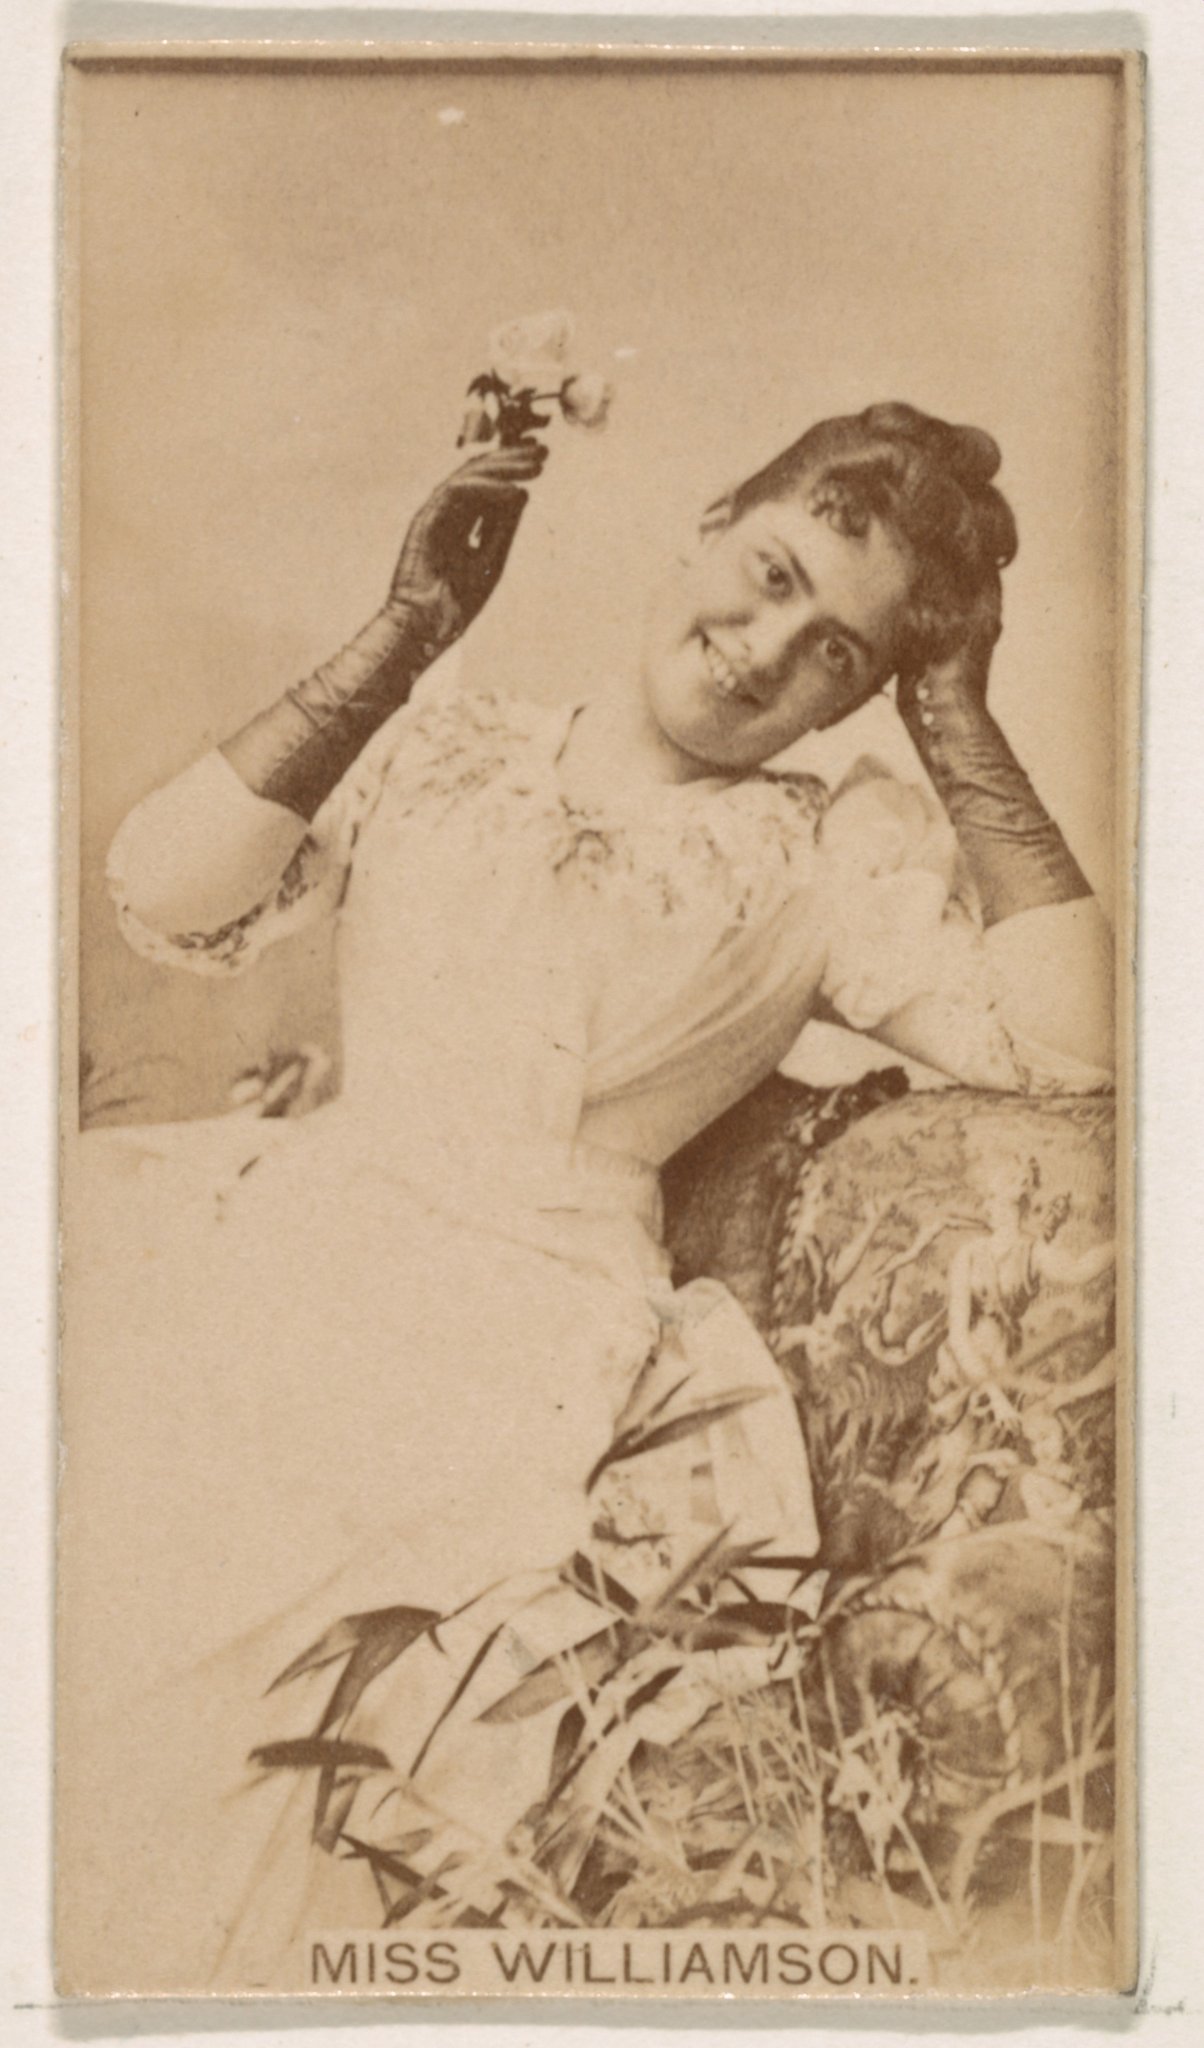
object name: photograph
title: Miss Williamson, from the Actresses series (N245) issued by Kinney Brothers to promote Sweet Caporal Cigarettes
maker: kinney brothers tobacco company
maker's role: publisher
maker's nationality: american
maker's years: 1869-2011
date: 1890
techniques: albumen silver print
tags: portraits,women,actresses